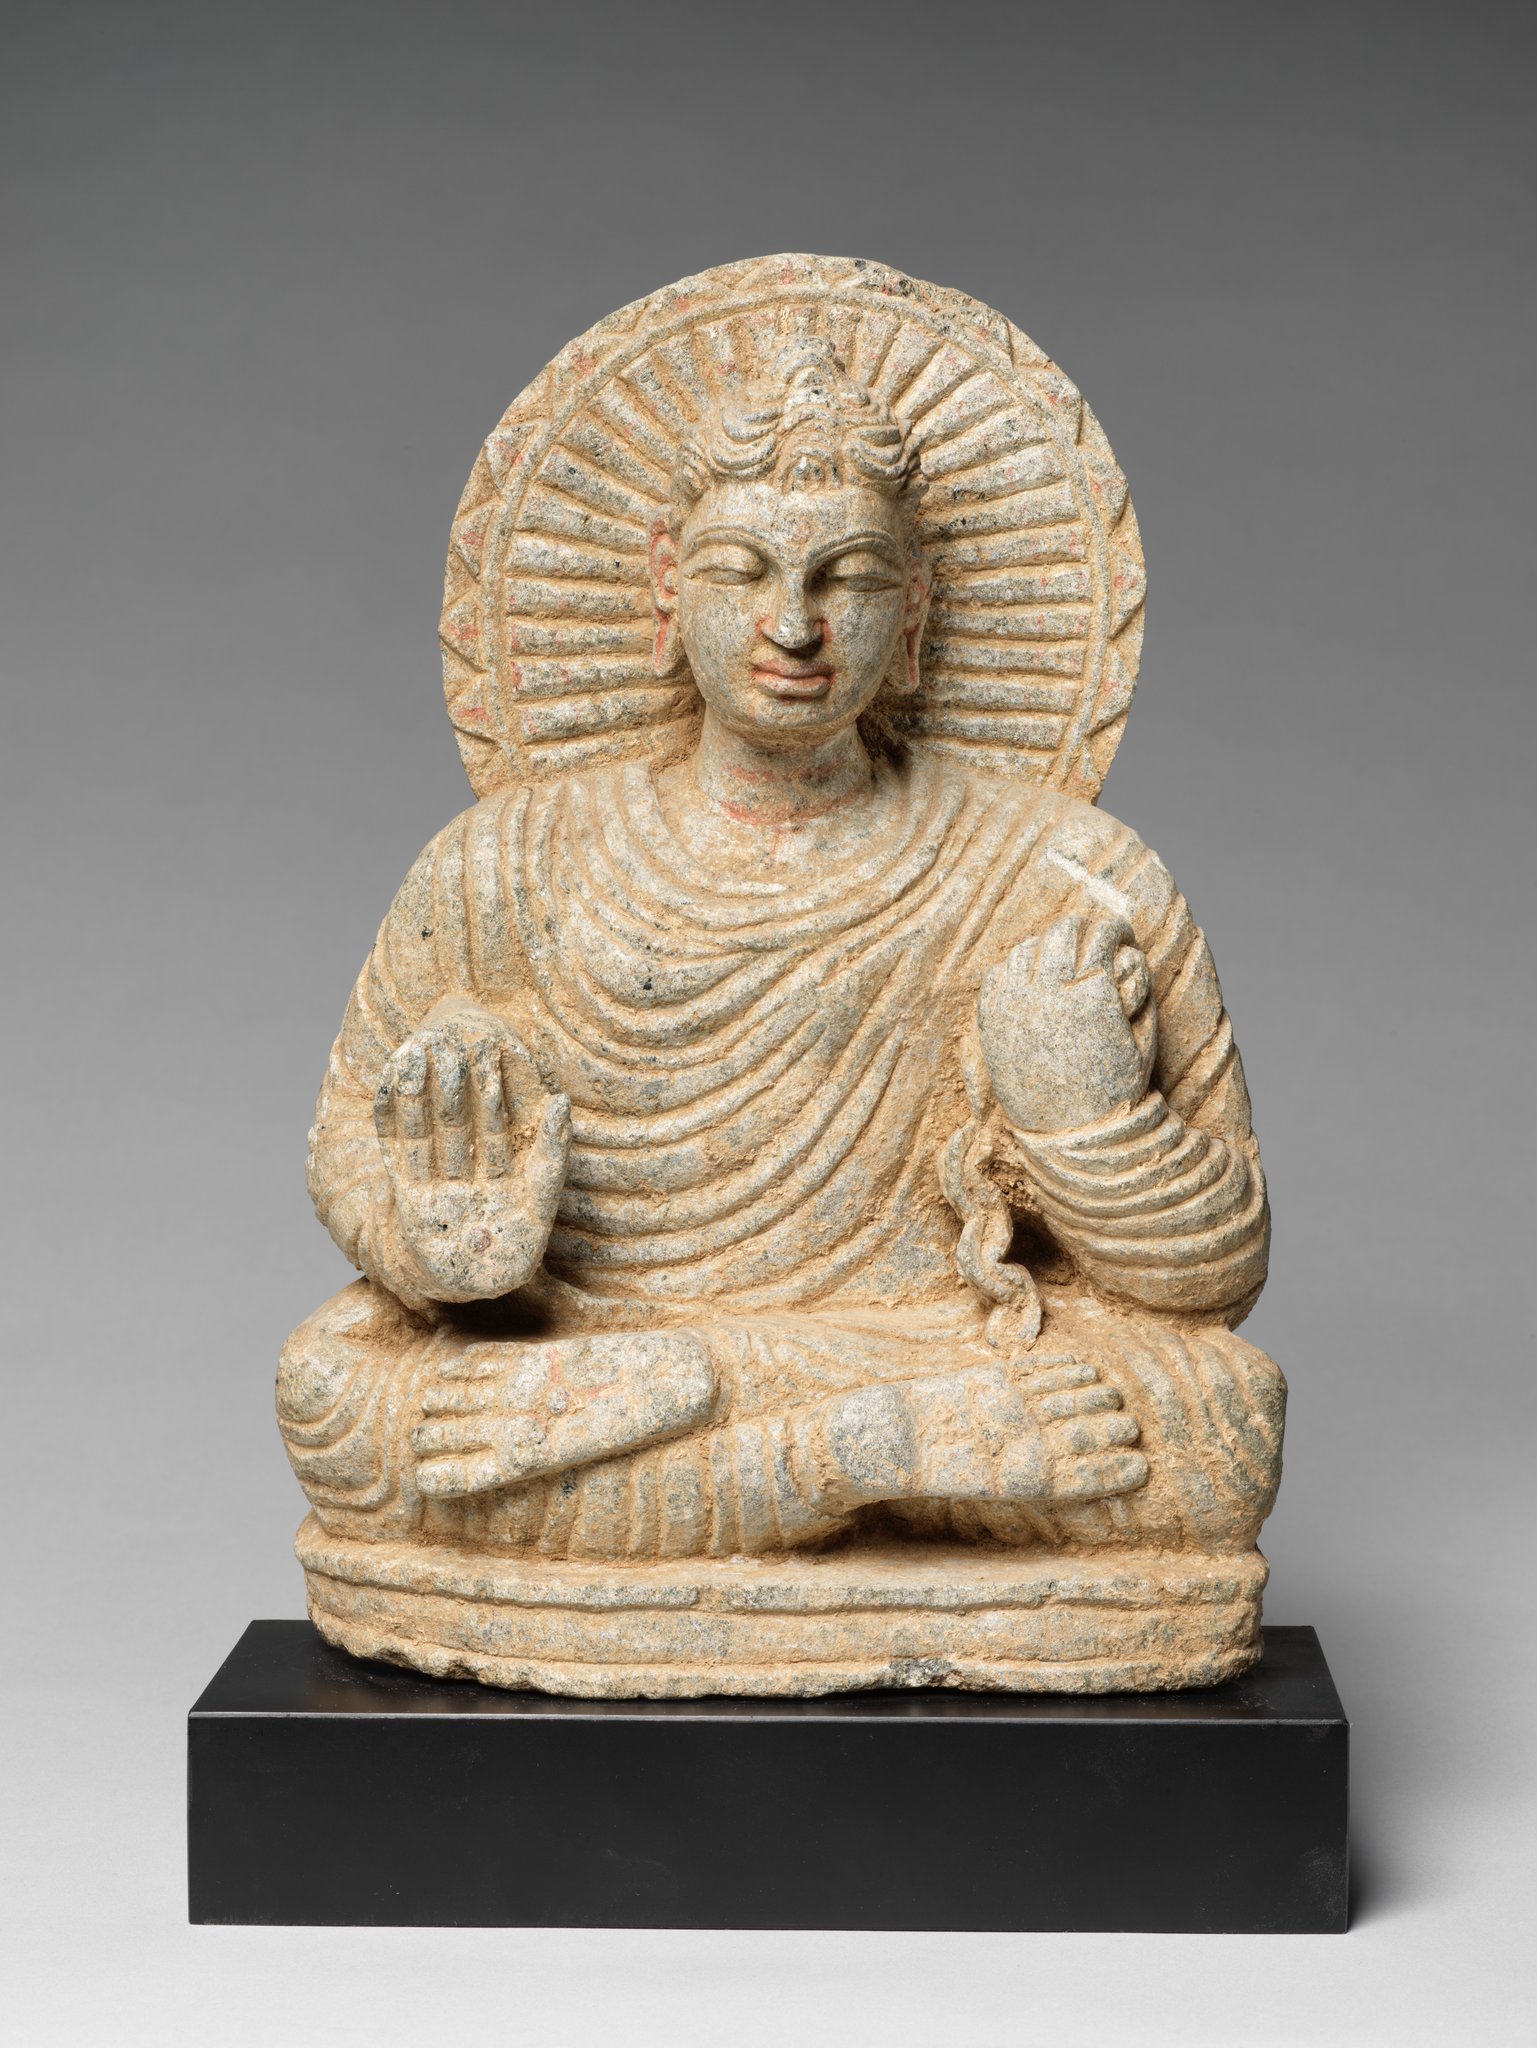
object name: figure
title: Seated Buddha (Study Collection)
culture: gandhara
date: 1901-2000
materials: stone